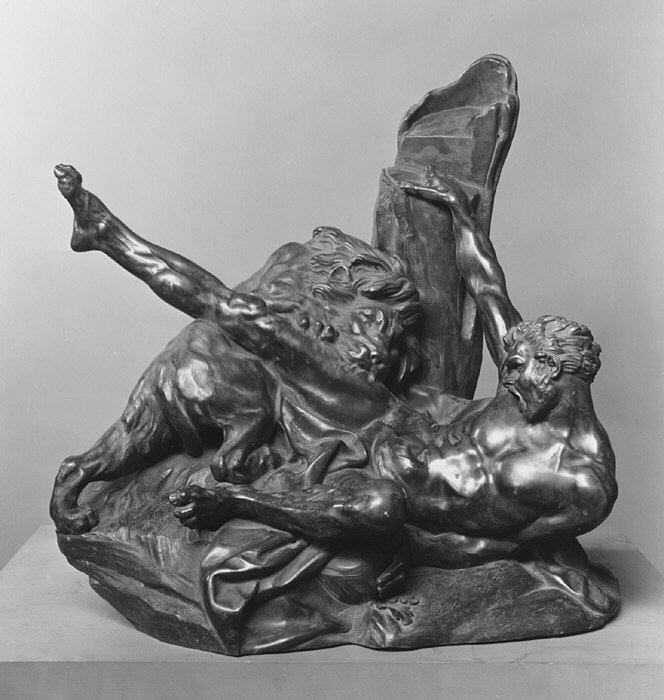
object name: statuette group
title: Milo of Crotona and the Lion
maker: etienne-maurice falconet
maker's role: artist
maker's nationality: french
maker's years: 1716-1791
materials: bronze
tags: men,lions